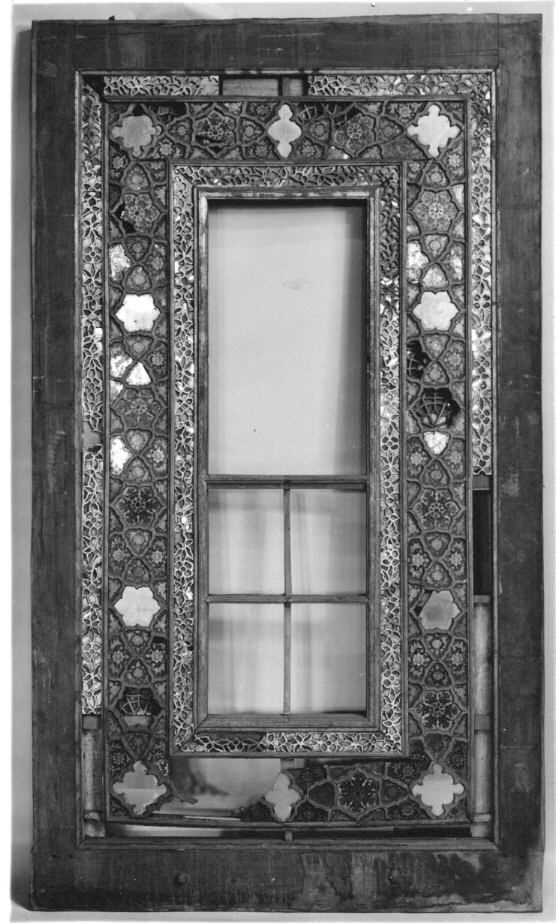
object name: window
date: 1801-1900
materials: glass, wood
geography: iran